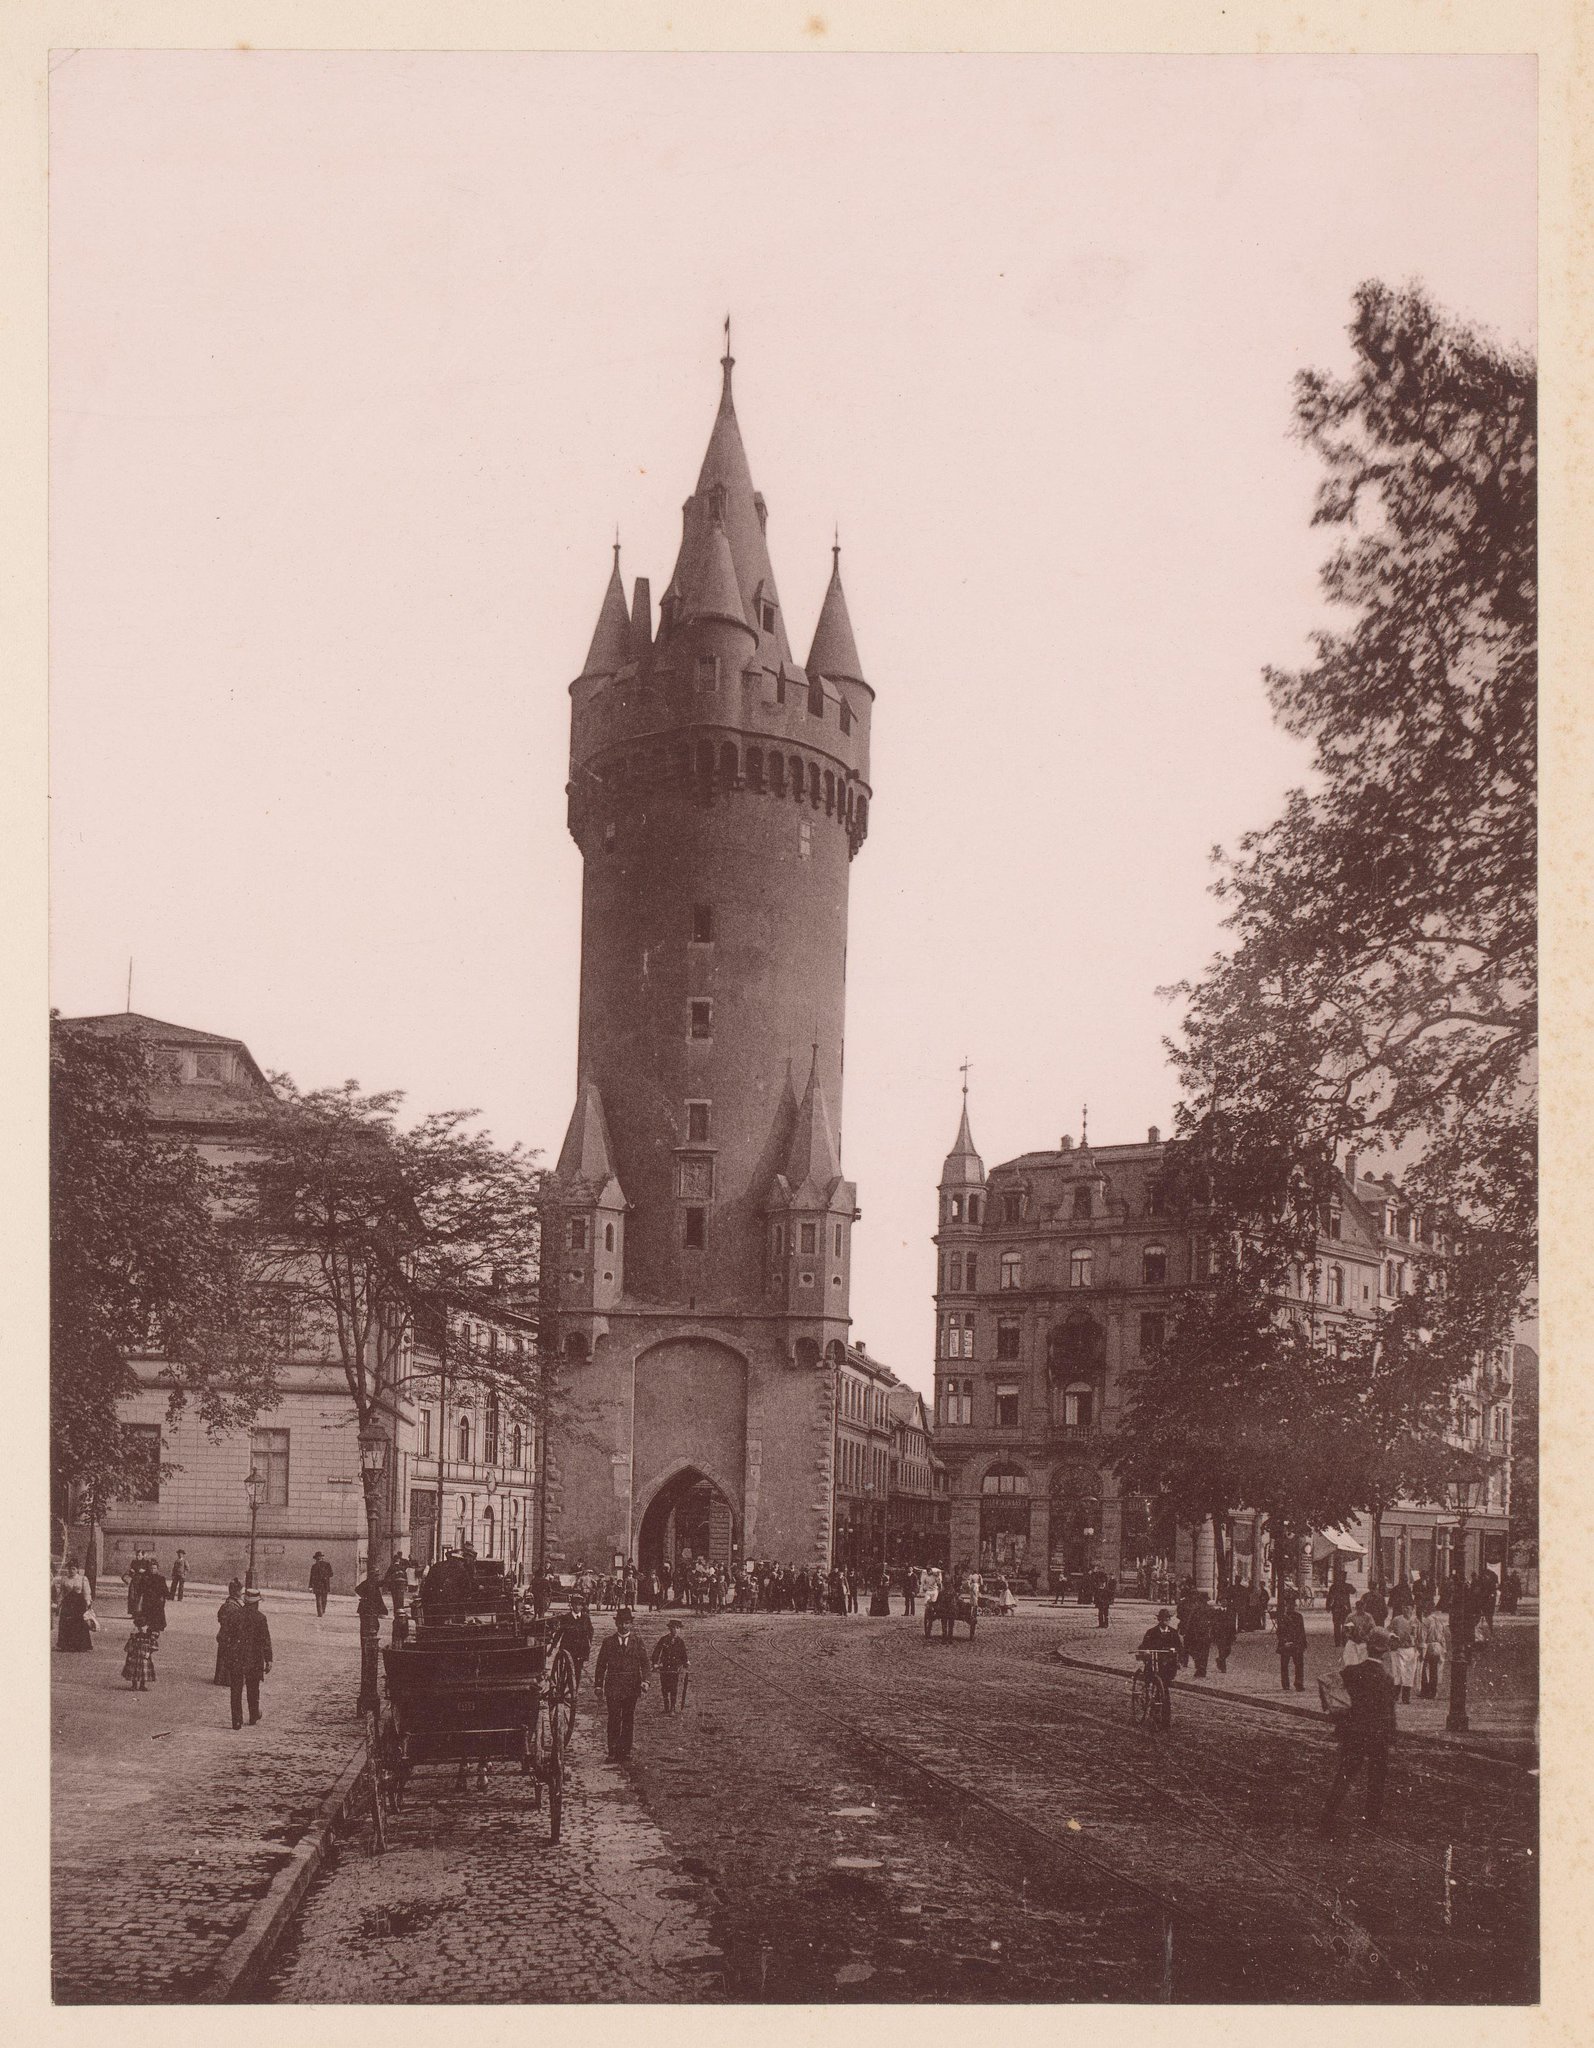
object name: photograph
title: Eschenheimner Turm, Frankfurt-am-Main, Duitsland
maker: Anonymous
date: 1875-1900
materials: cardboard, photographic support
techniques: photograph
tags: frankfurt am main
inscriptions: caption: ‘Frankfurt’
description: Eschenheimner Turm, Frankfurt-am-Main, Duitsland.